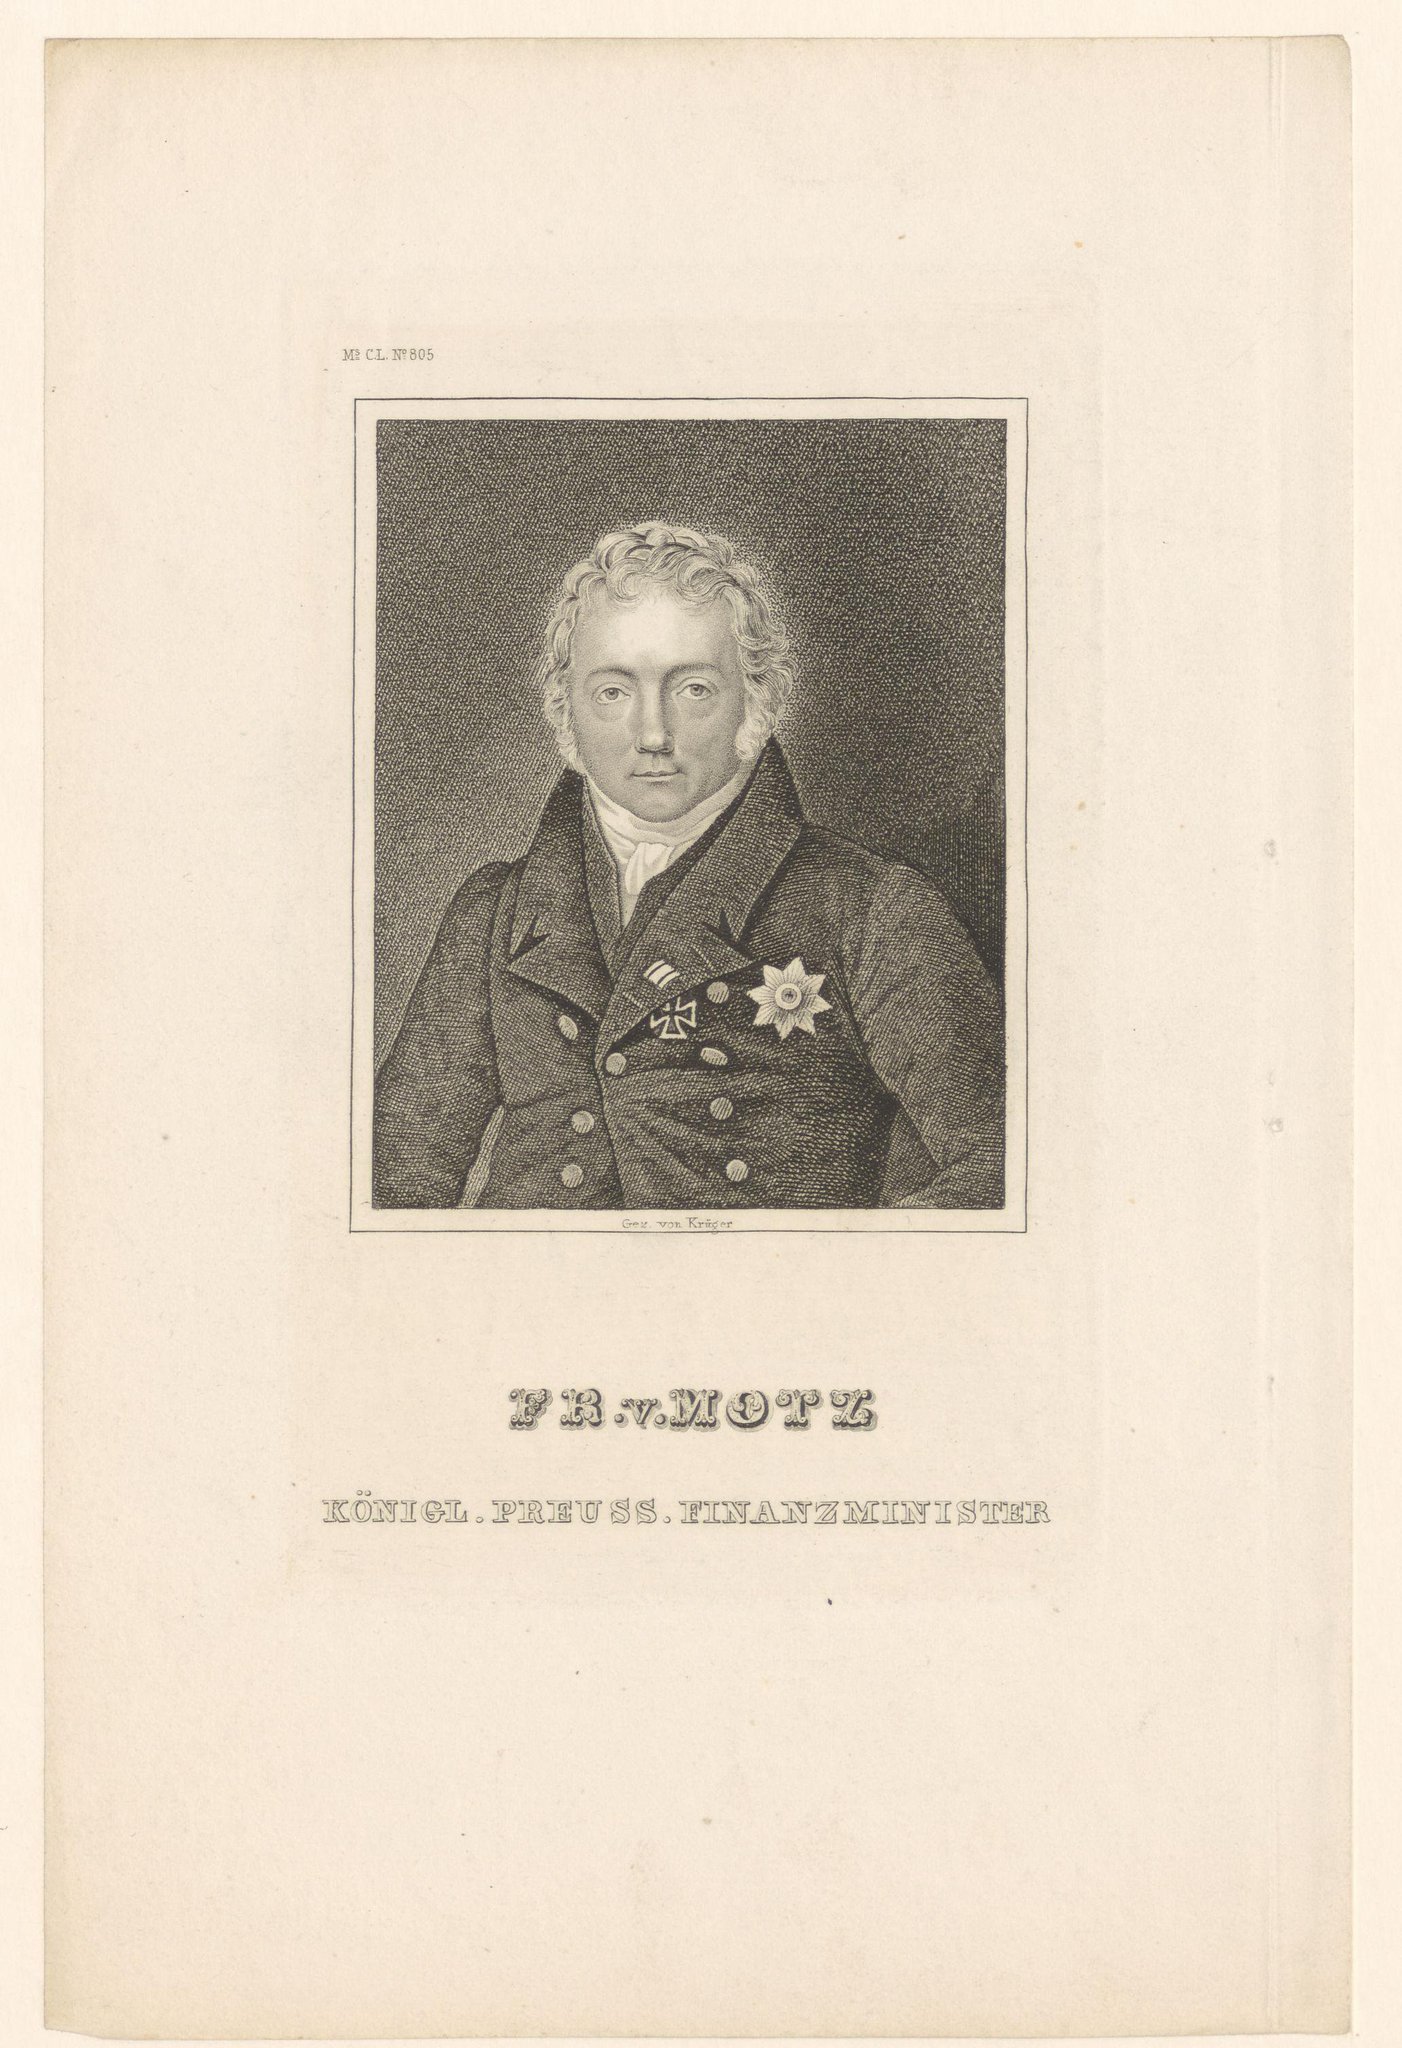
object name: book illustration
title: Portret van Friedrich von Motz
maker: johann conrad krüger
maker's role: artist, painter, print maker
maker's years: 1733-1791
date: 1840-1855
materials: paper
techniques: stippling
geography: hildburghausen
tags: knighthood order: teutonic order - insignia of a knighthood order, e.g.: badge, chain (with name of order), knighthood order (red eagle order), historical persons, politician, e.g. party leader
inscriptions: collector's mark: Lugt 2228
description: Prent uit: Meyer, Joseph. Das Grosse Conversations-Lexikon für die gebildeten Stände. Hildburghausen: Bibliographisches Institut, [1840-1855].